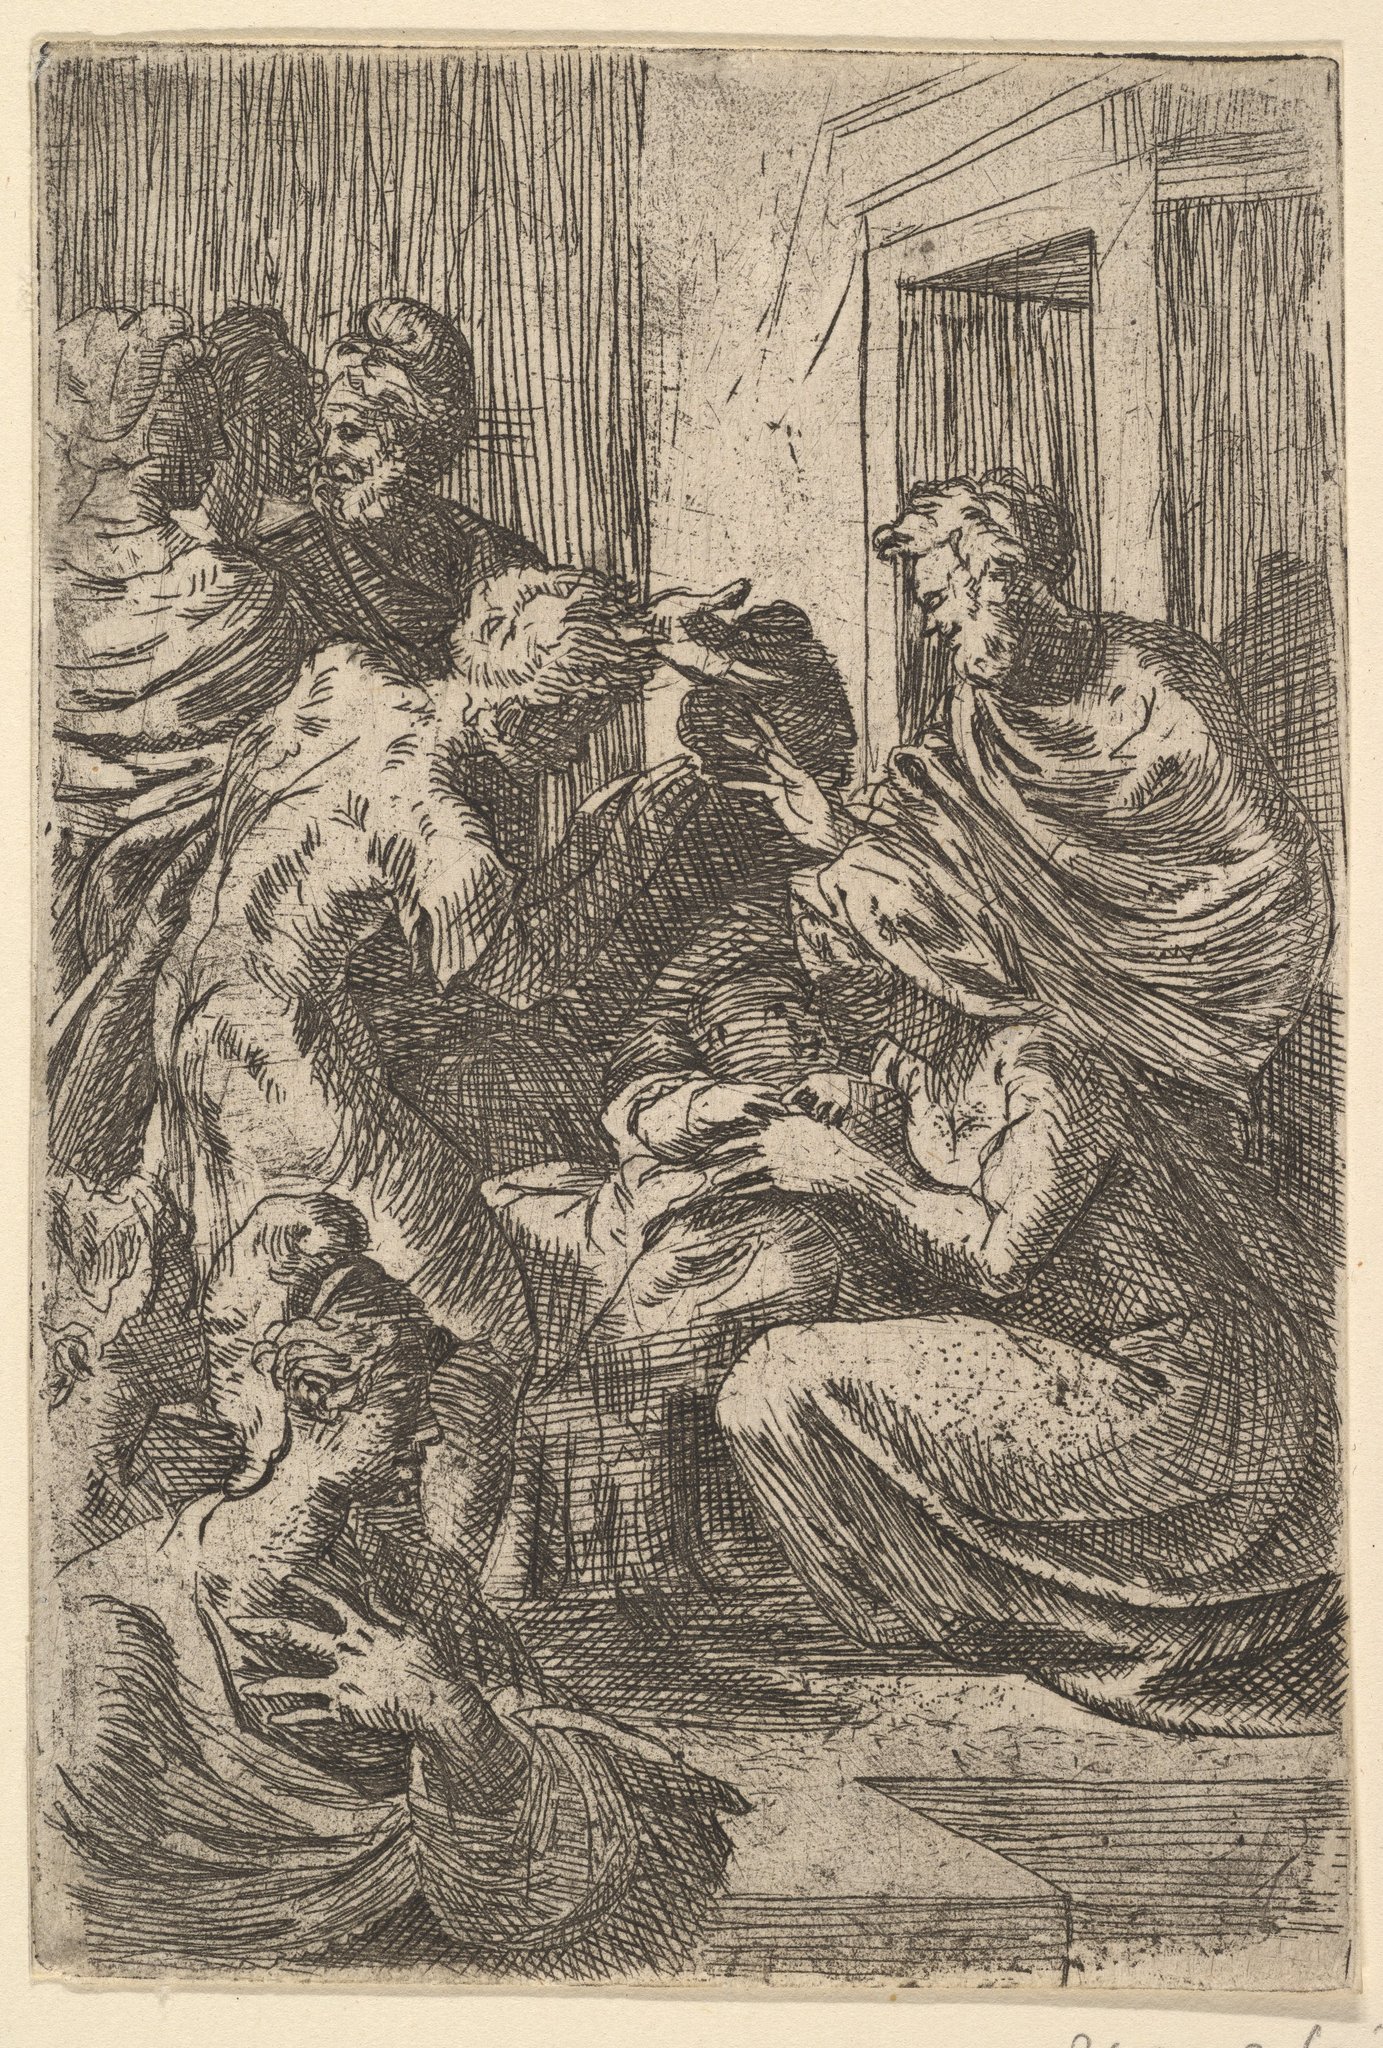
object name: print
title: Nativity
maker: anonymous, italian, 16th century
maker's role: artist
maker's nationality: italian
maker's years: 1500-1600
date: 1501-1600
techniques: etching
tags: men,women,christ,virgin mary,nativity